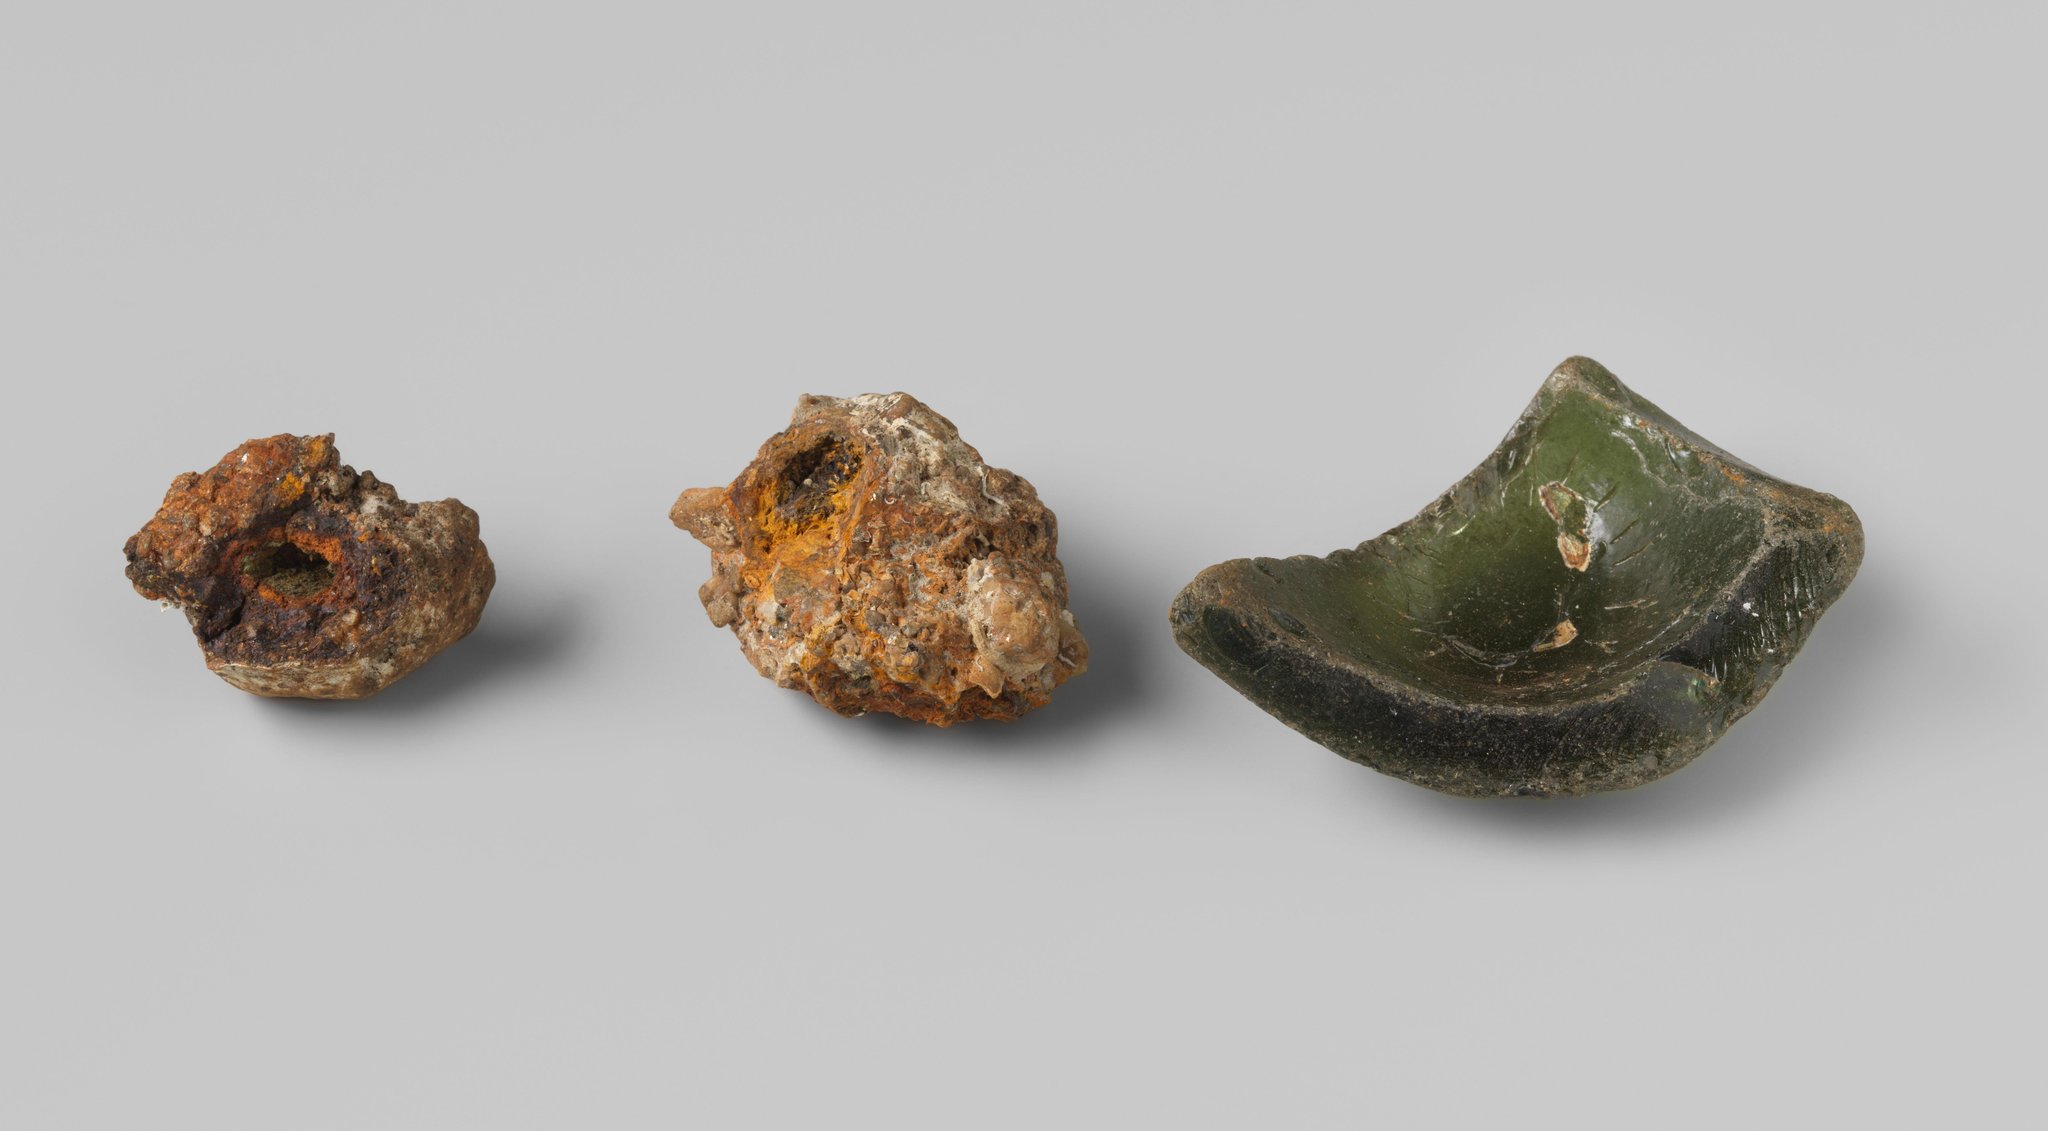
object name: sherd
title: Glasscherf en concretie uit het wrak van de Oostindiëvaarder Hollandia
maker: Anonymous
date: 1700-1743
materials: stone, glass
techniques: green glass